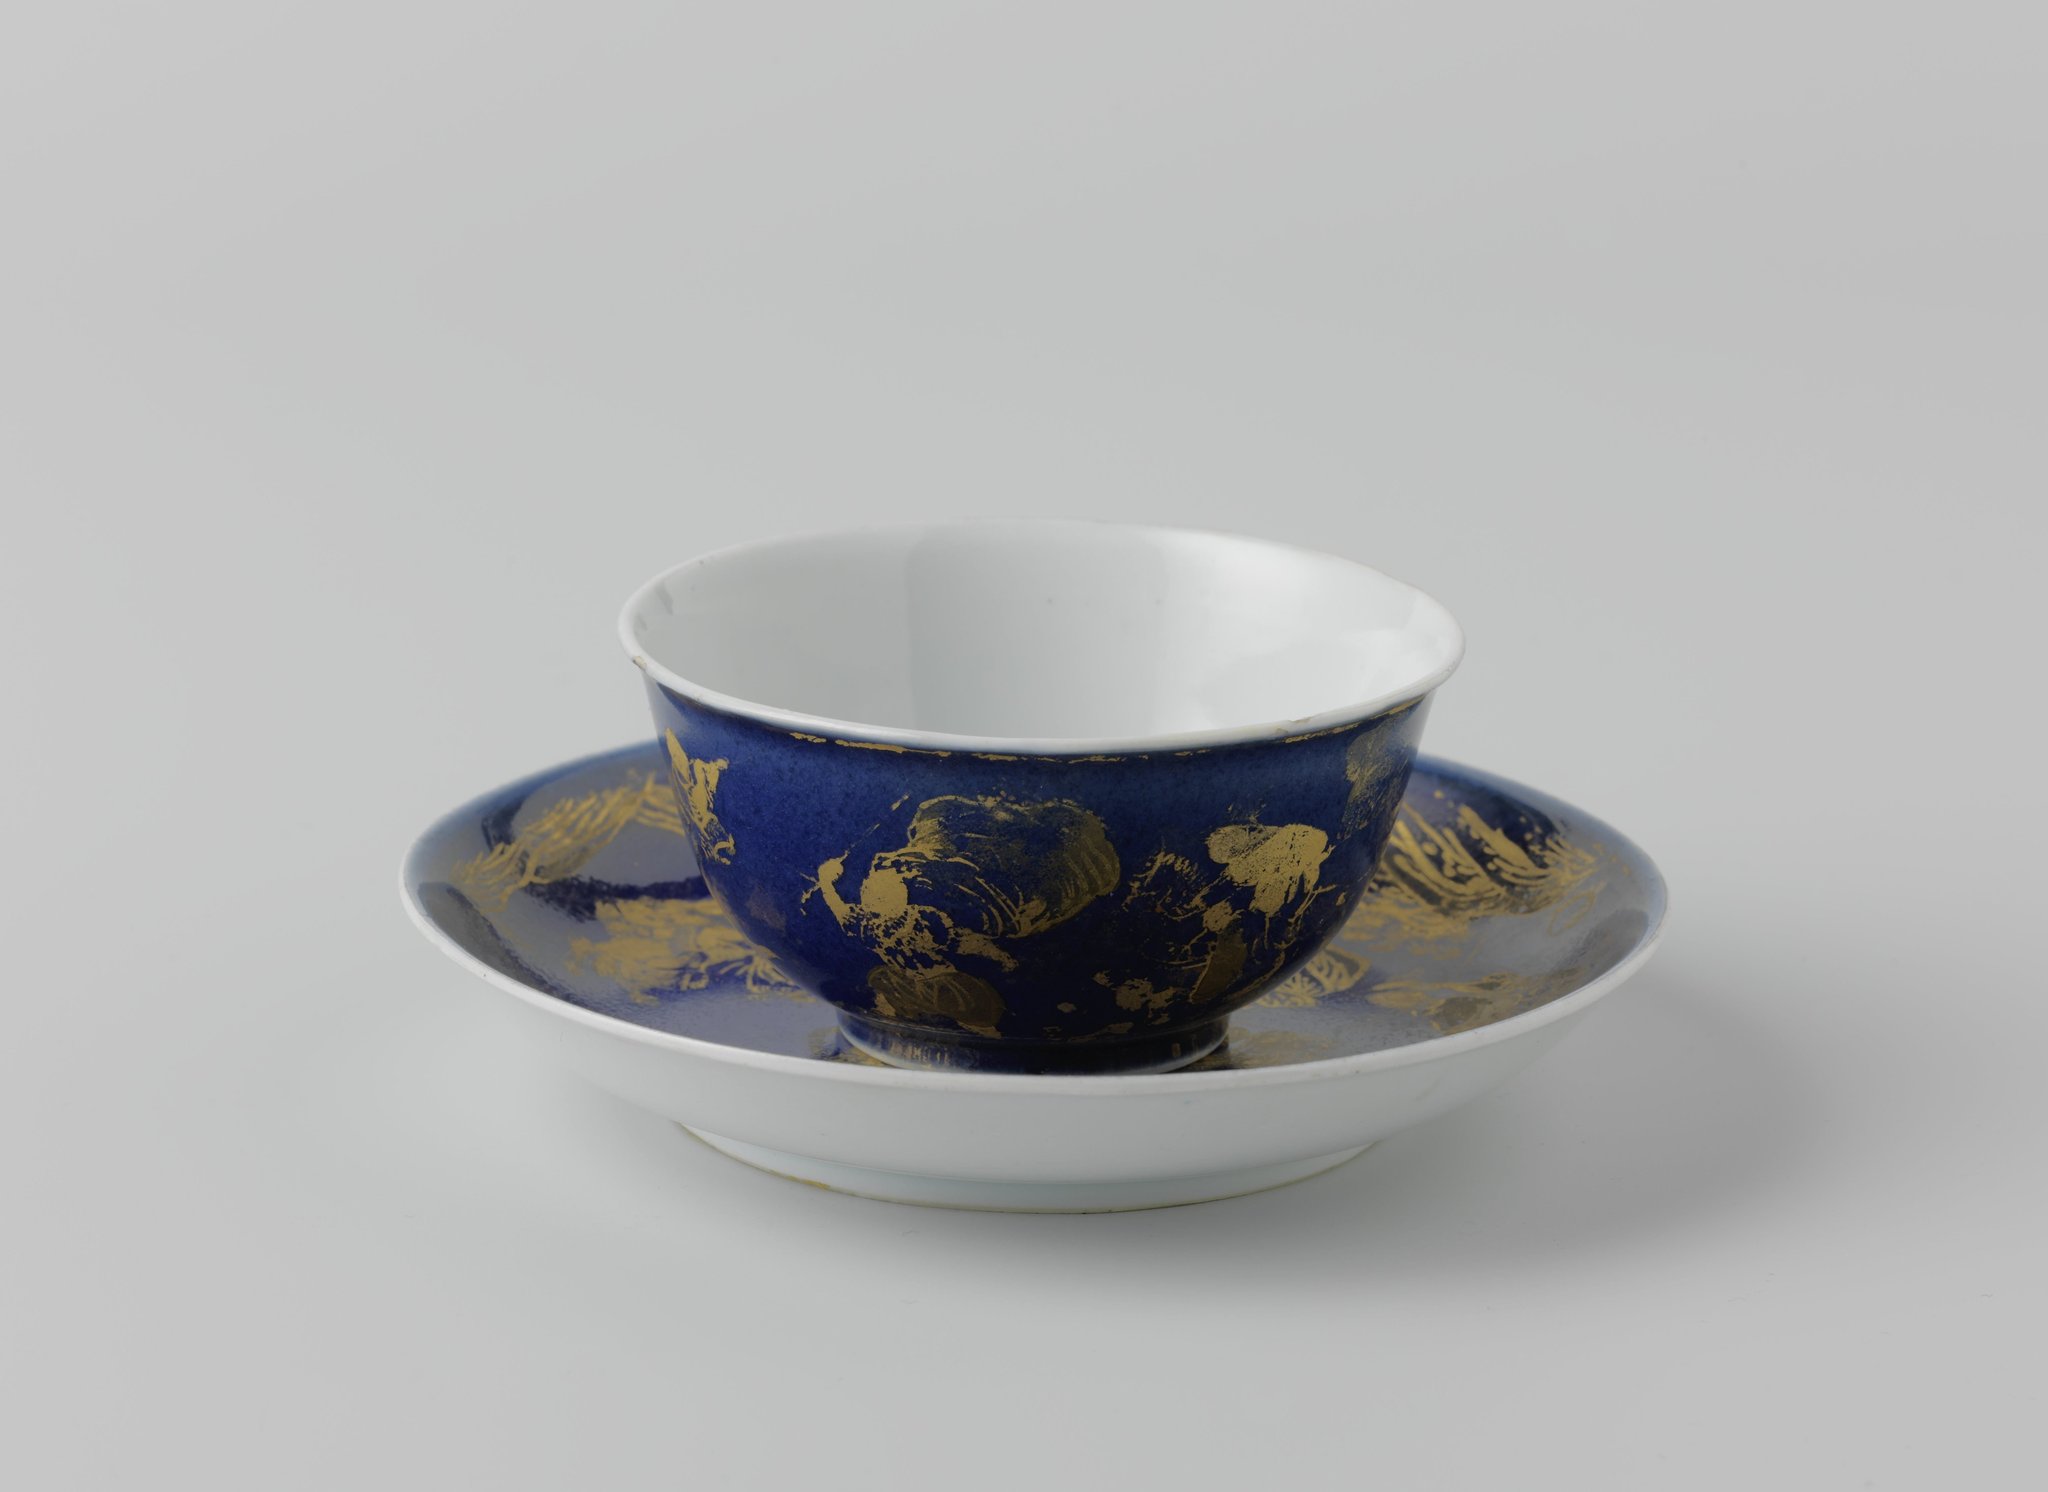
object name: kop en schotel, kop en schotel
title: Bell-shaped cup and saucer with powder blue, figures, rocks and trees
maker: Anonymous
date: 1700-1724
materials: cobalt, glaze, gold, paint, porcelain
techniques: firing, gilding, turning, vitrification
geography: china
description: Klokvormige kop en schotel van porselein, beschilderd in onderglazuur blauw en goud. De voorzijde van de schotel en de buitenzijde van de kop zijn volledig bedekt met bleu poudré (poederblauw) met hierop mannen en vrouwen, sommige te paard, met rotsen en dieren in goud. De kop met dezelfde decoratie. Een chip in de rand van de kop. Bleu poudré met goud.